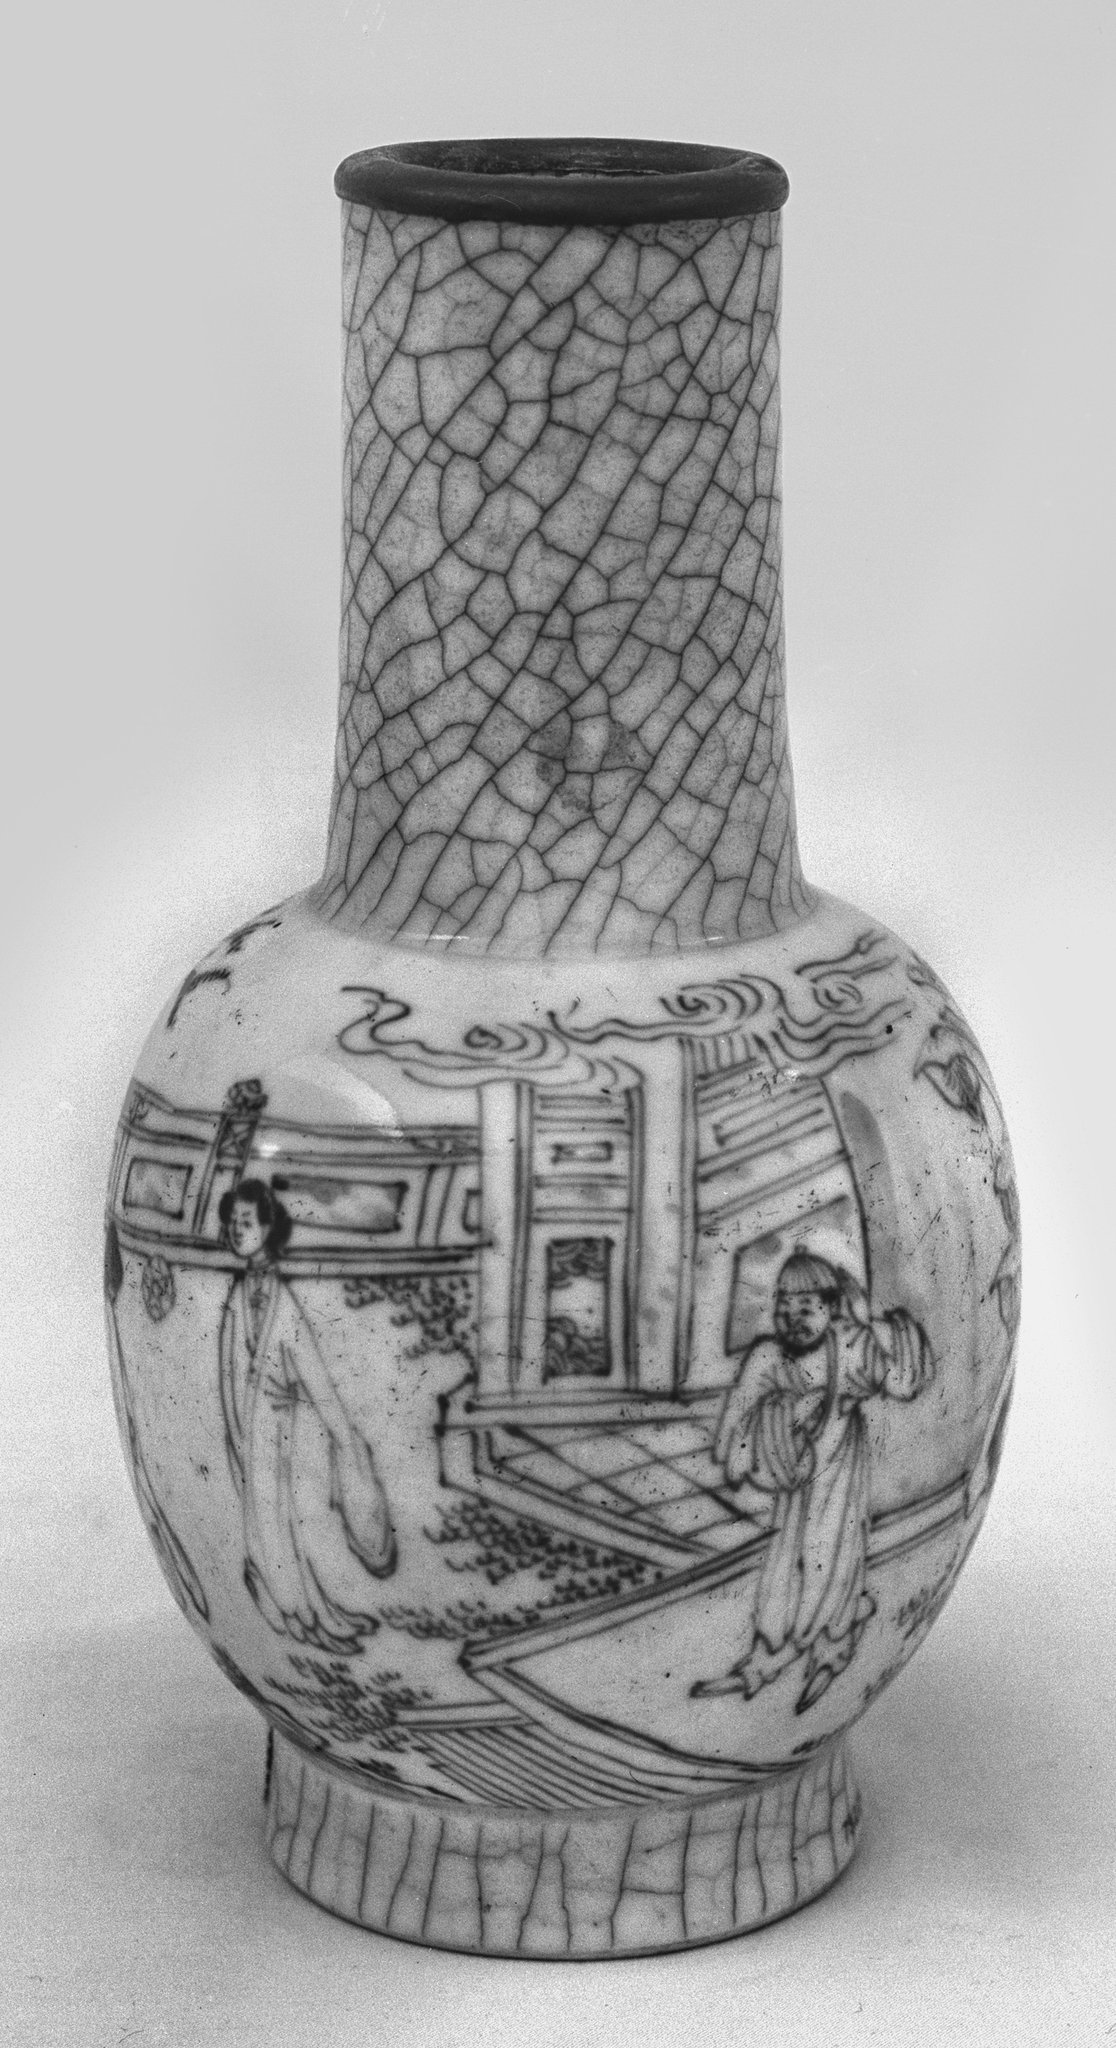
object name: vase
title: Vase with figures in a garden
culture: chinese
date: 1601-1700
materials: cobalt, copper, glaze, porcelain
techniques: painting, underglaze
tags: men,women